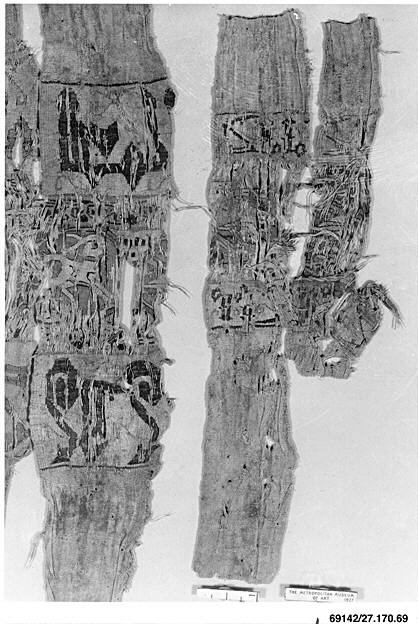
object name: textile fragment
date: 1001-1100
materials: linen, silk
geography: egypt